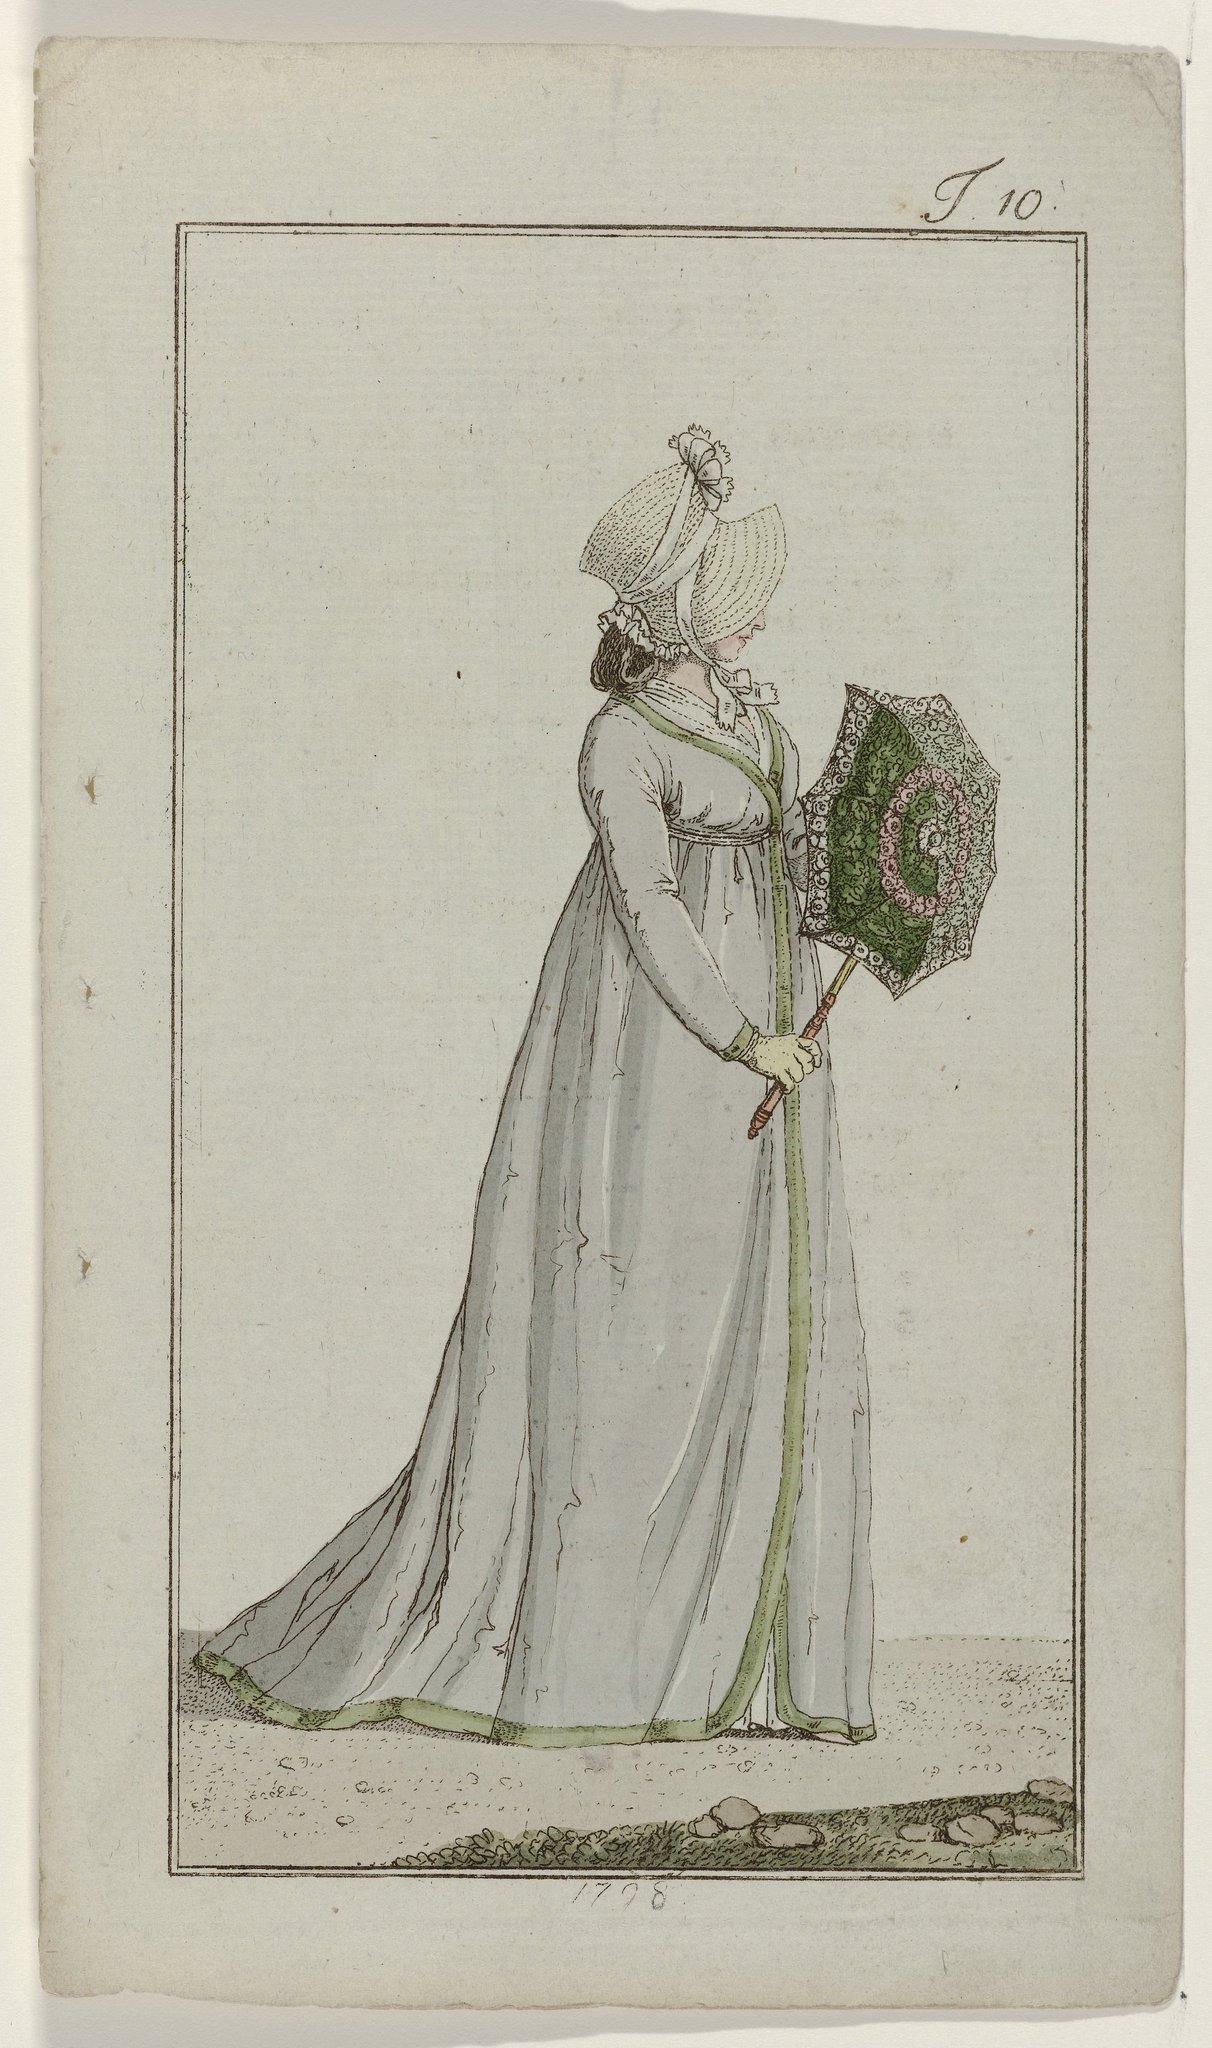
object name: fashion print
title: Journal des Luxus und der Moden, 1798, T 10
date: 1798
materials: paper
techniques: etching, hand coloring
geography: weimar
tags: head-gear (+ women's clothes), fashion plates, shoes, sandals (+ women's clothes), gloves, mittens, etc. (+ women's clothes), dress, gown (+ women's clothes), piece of clothing covering the breast or décolleté (fichu) (+ women's clothes), parasol, sunshade (+ women's clothes)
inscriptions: date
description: Vrouw gekleed in een japon met overslag, lange mouwen en sleep, afgezet met een bies in contrasterende kleur. In de handen een parasol met een gekanteld dek met bloem- en bladmotief. Verdere accessoires: luifelhoed, fichu, ceintuur, handschoen. Prent uit het modetijdschrift Journal des Luxus und der Moden, uitgegeven door Friedrich Justin Bertuch en Georg Melchior Kraus, Weimar, 1786-1826.